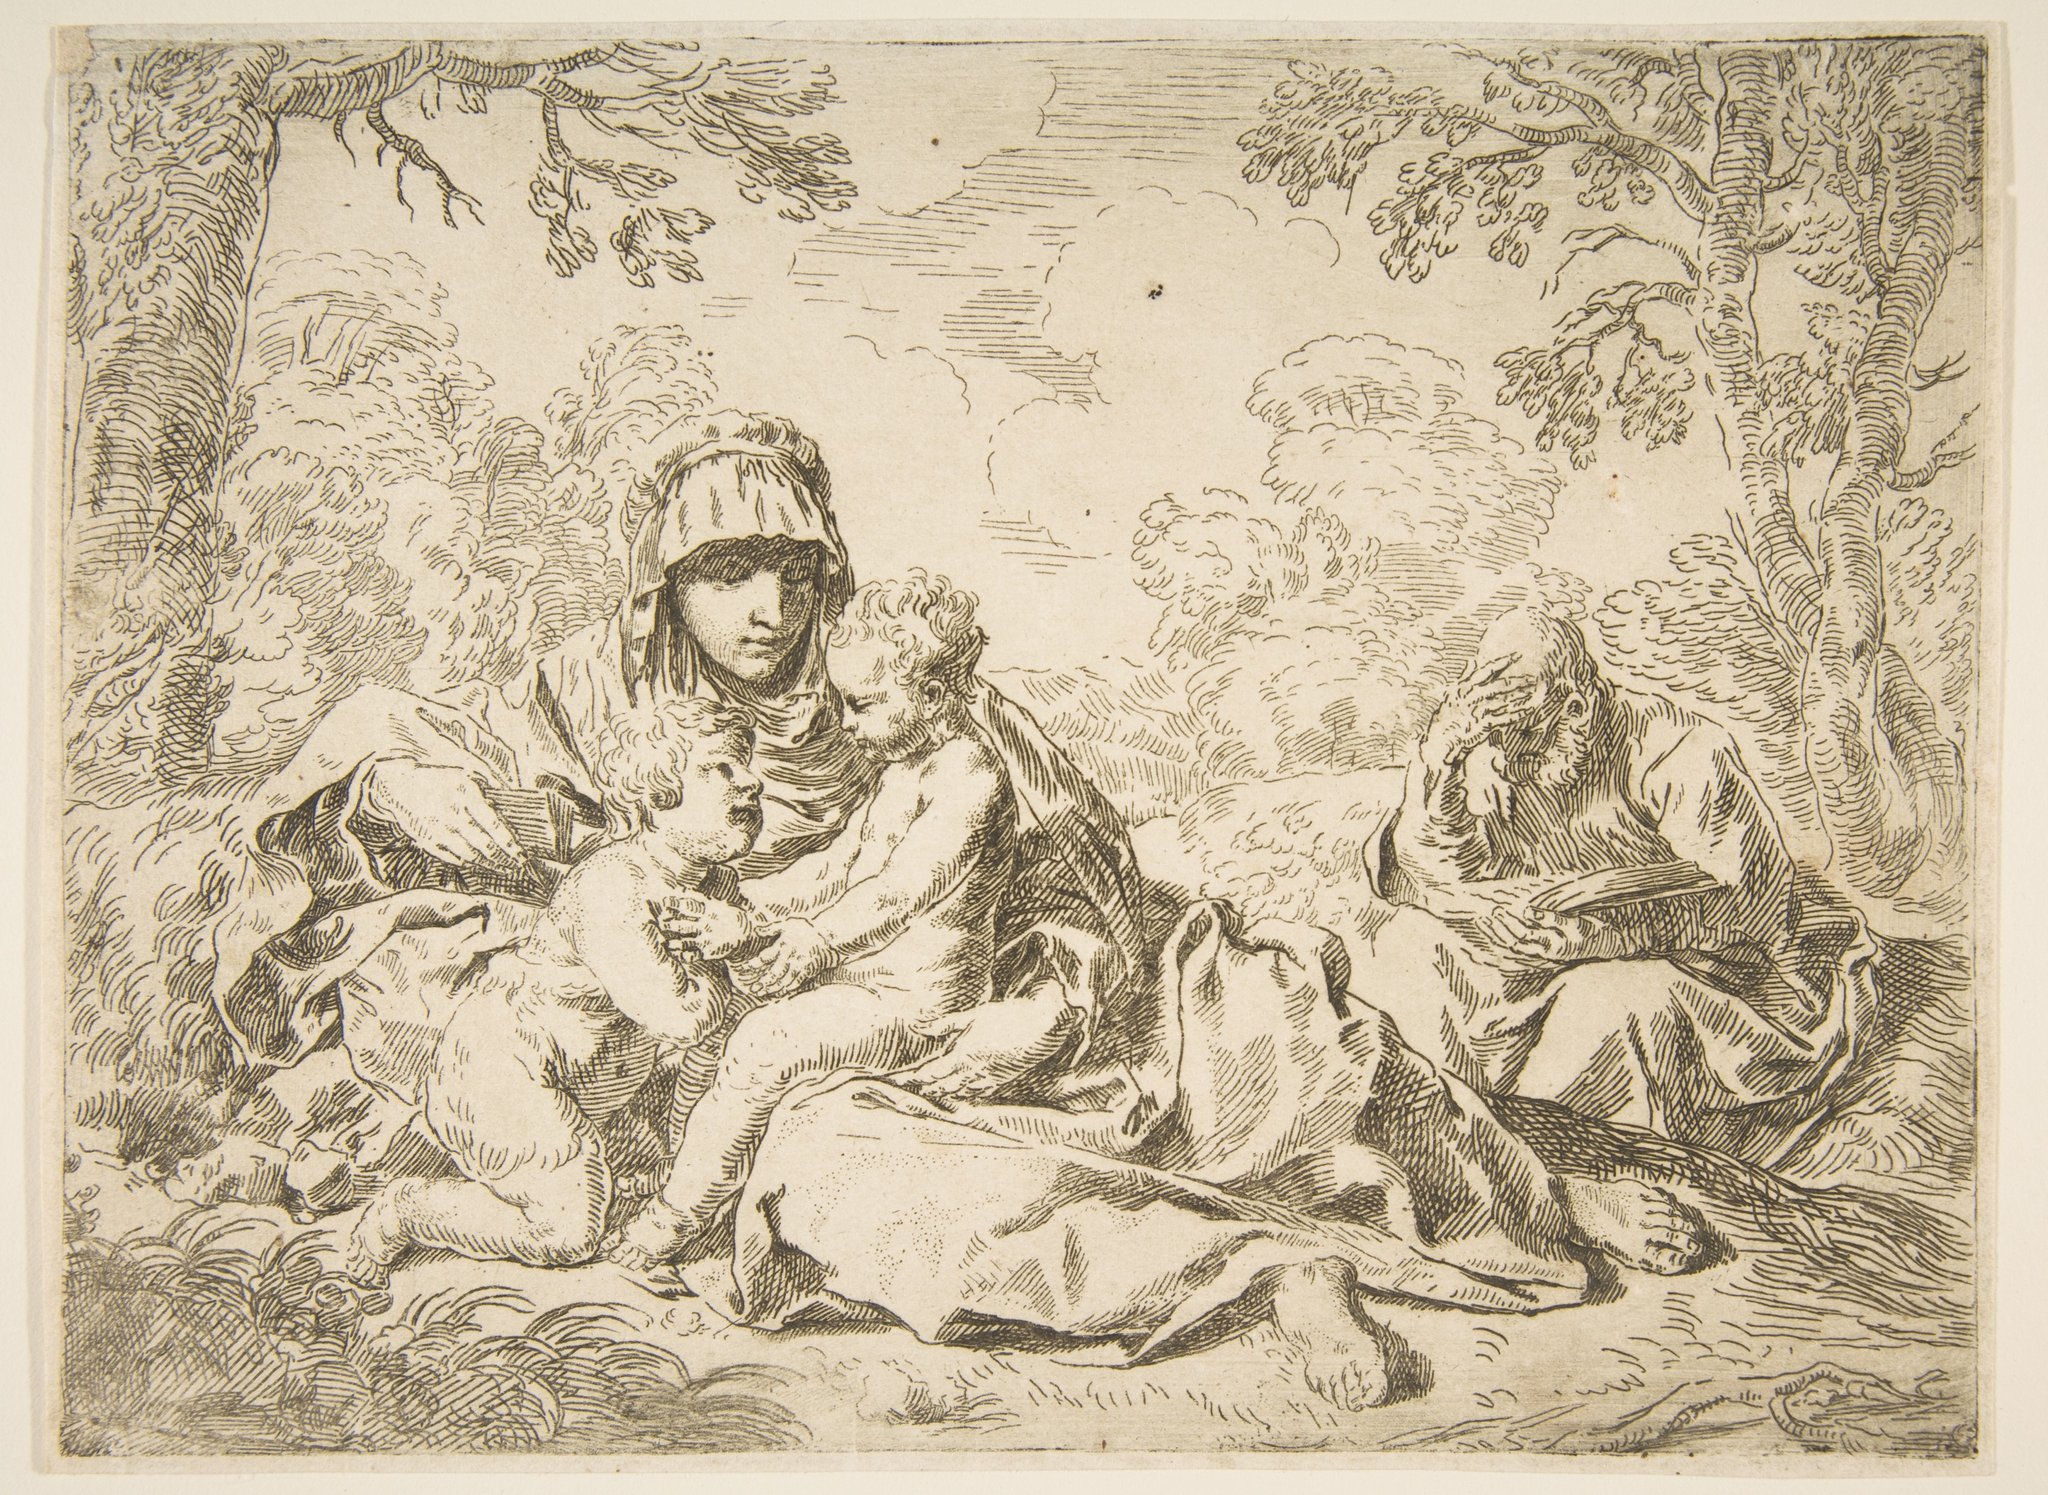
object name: print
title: The Holy Family with Saint John the Baptist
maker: simone cantarini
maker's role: artist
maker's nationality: italian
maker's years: 1612-1648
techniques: etching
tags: trees,holy family,saint john the baptist